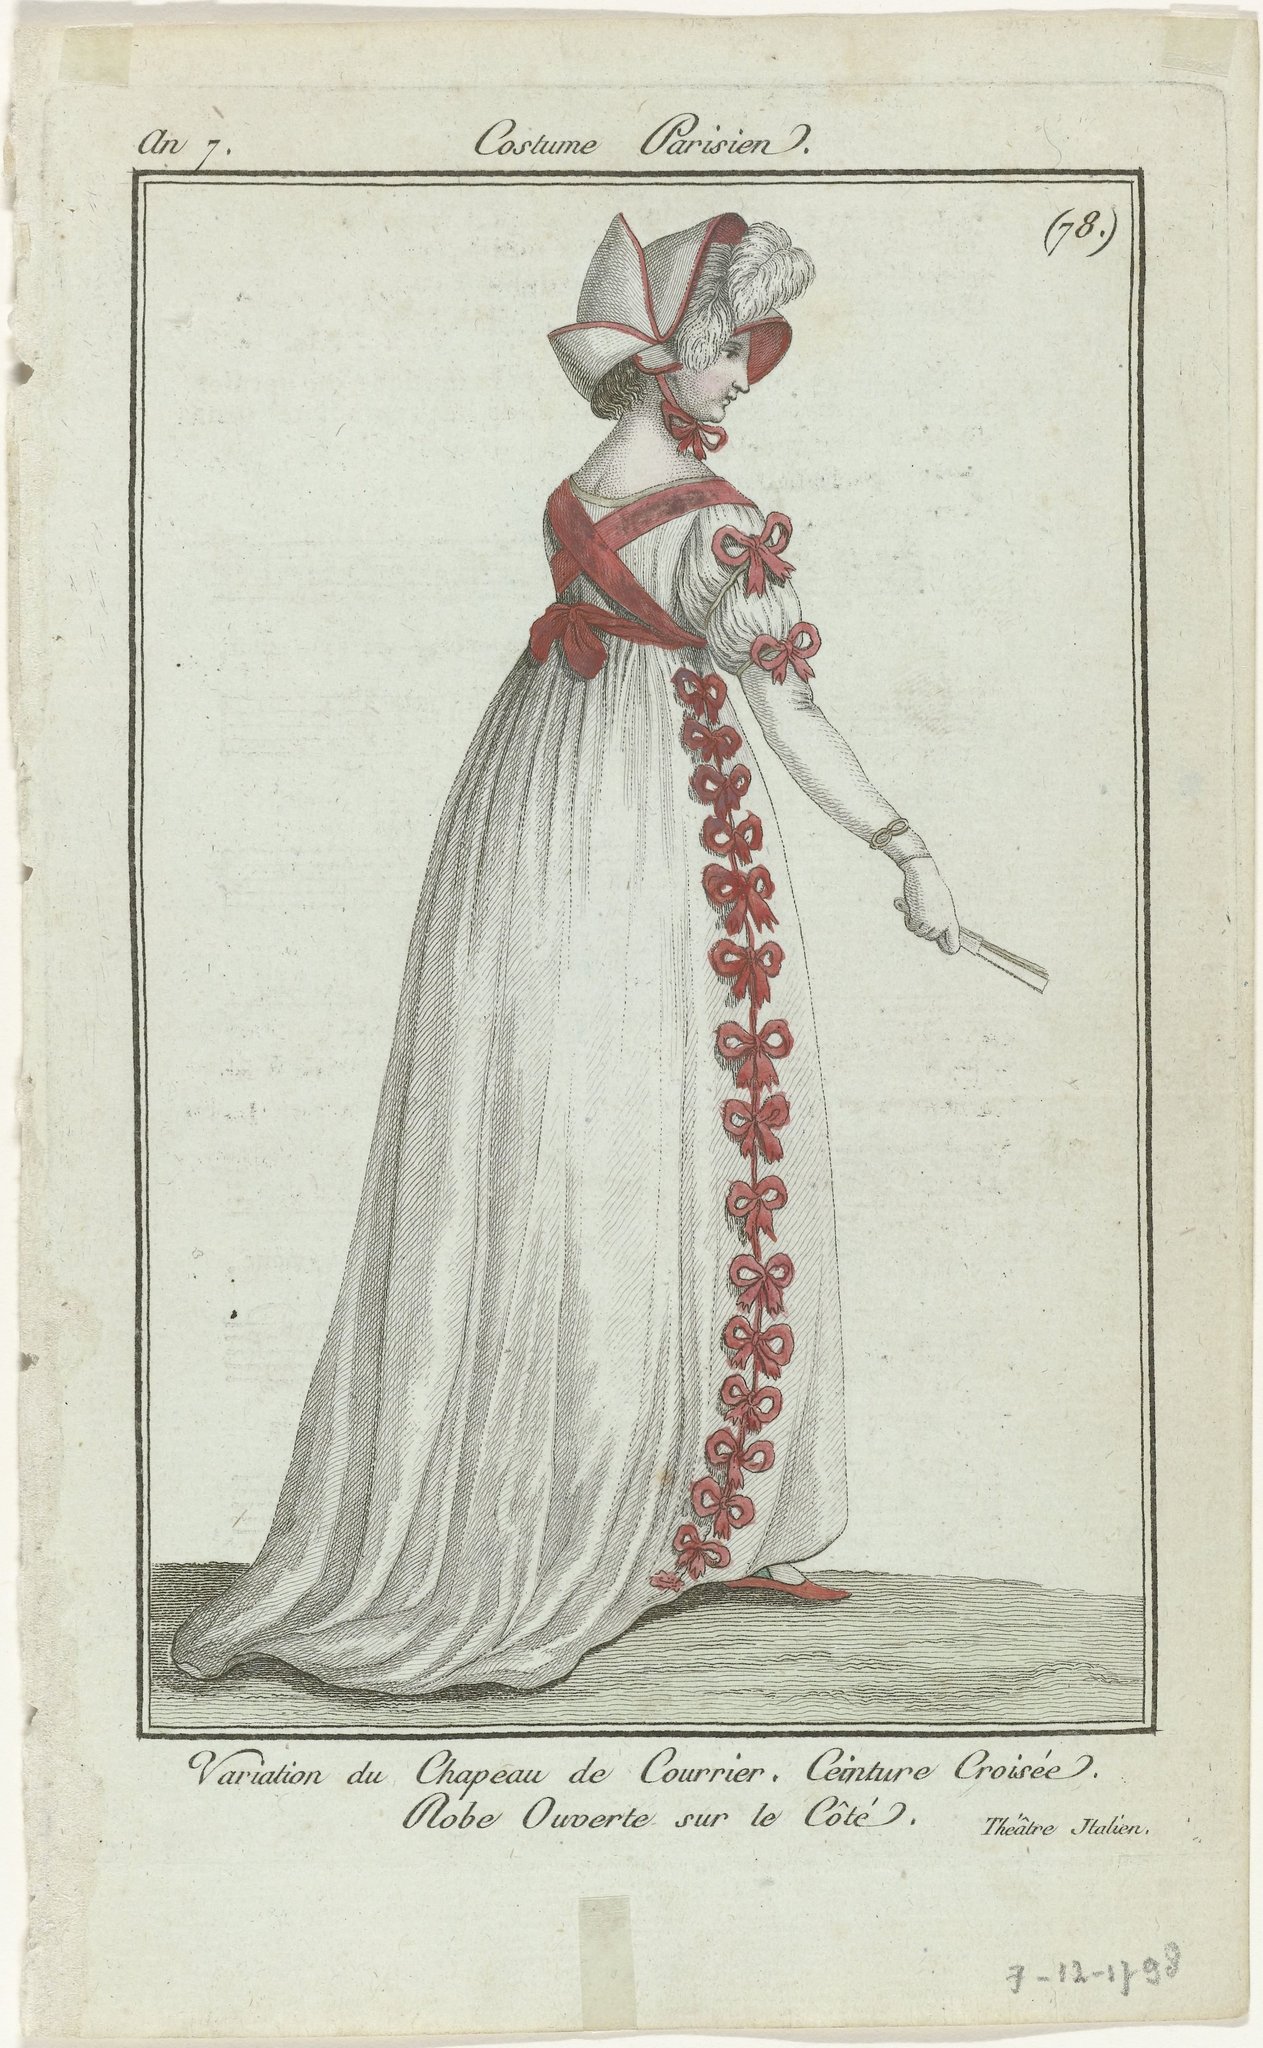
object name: fashion print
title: Journal des Dames et des Modes, Costume Parisien, 7 décembre 1798, An 7, (78.) : Variation du Chapeau (...)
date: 1798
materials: paper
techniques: engraving, hand coloring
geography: paris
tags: bow (ornamental part of clothing) (+ women's clothes), fashion plates, head-gear: hat (+ women's clothes), dress, gown (+ women's clothes), fan (+ women's clothes), bracelet, wristlet (+ women's clothes), belt, girdle, waistband (+ women's clothes)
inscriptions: title: ‘Costume Parisien.’, caption: ‘Variation du Chapeau de Courrier. Ceinture Croisée. Robe Ouverte sur le Côté.’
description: Vrouw, op de rug gezien, met op het hoofd een variatie op de hoed: 'Chapeau de Courrier'. Zij draagt een japon, die aan de zijkant open is. Ceintuur op de rug gekruist. Strikken op de mouw en aan de zijkant van de japon. Verdere accessoires: armband, waaier, platte schoen met puntige neus. De prent maakt deel uit van het modetijdschrift Journal des Dames et des Modes, uitgegeven door Sellèque, Parijs, 1797-1839.